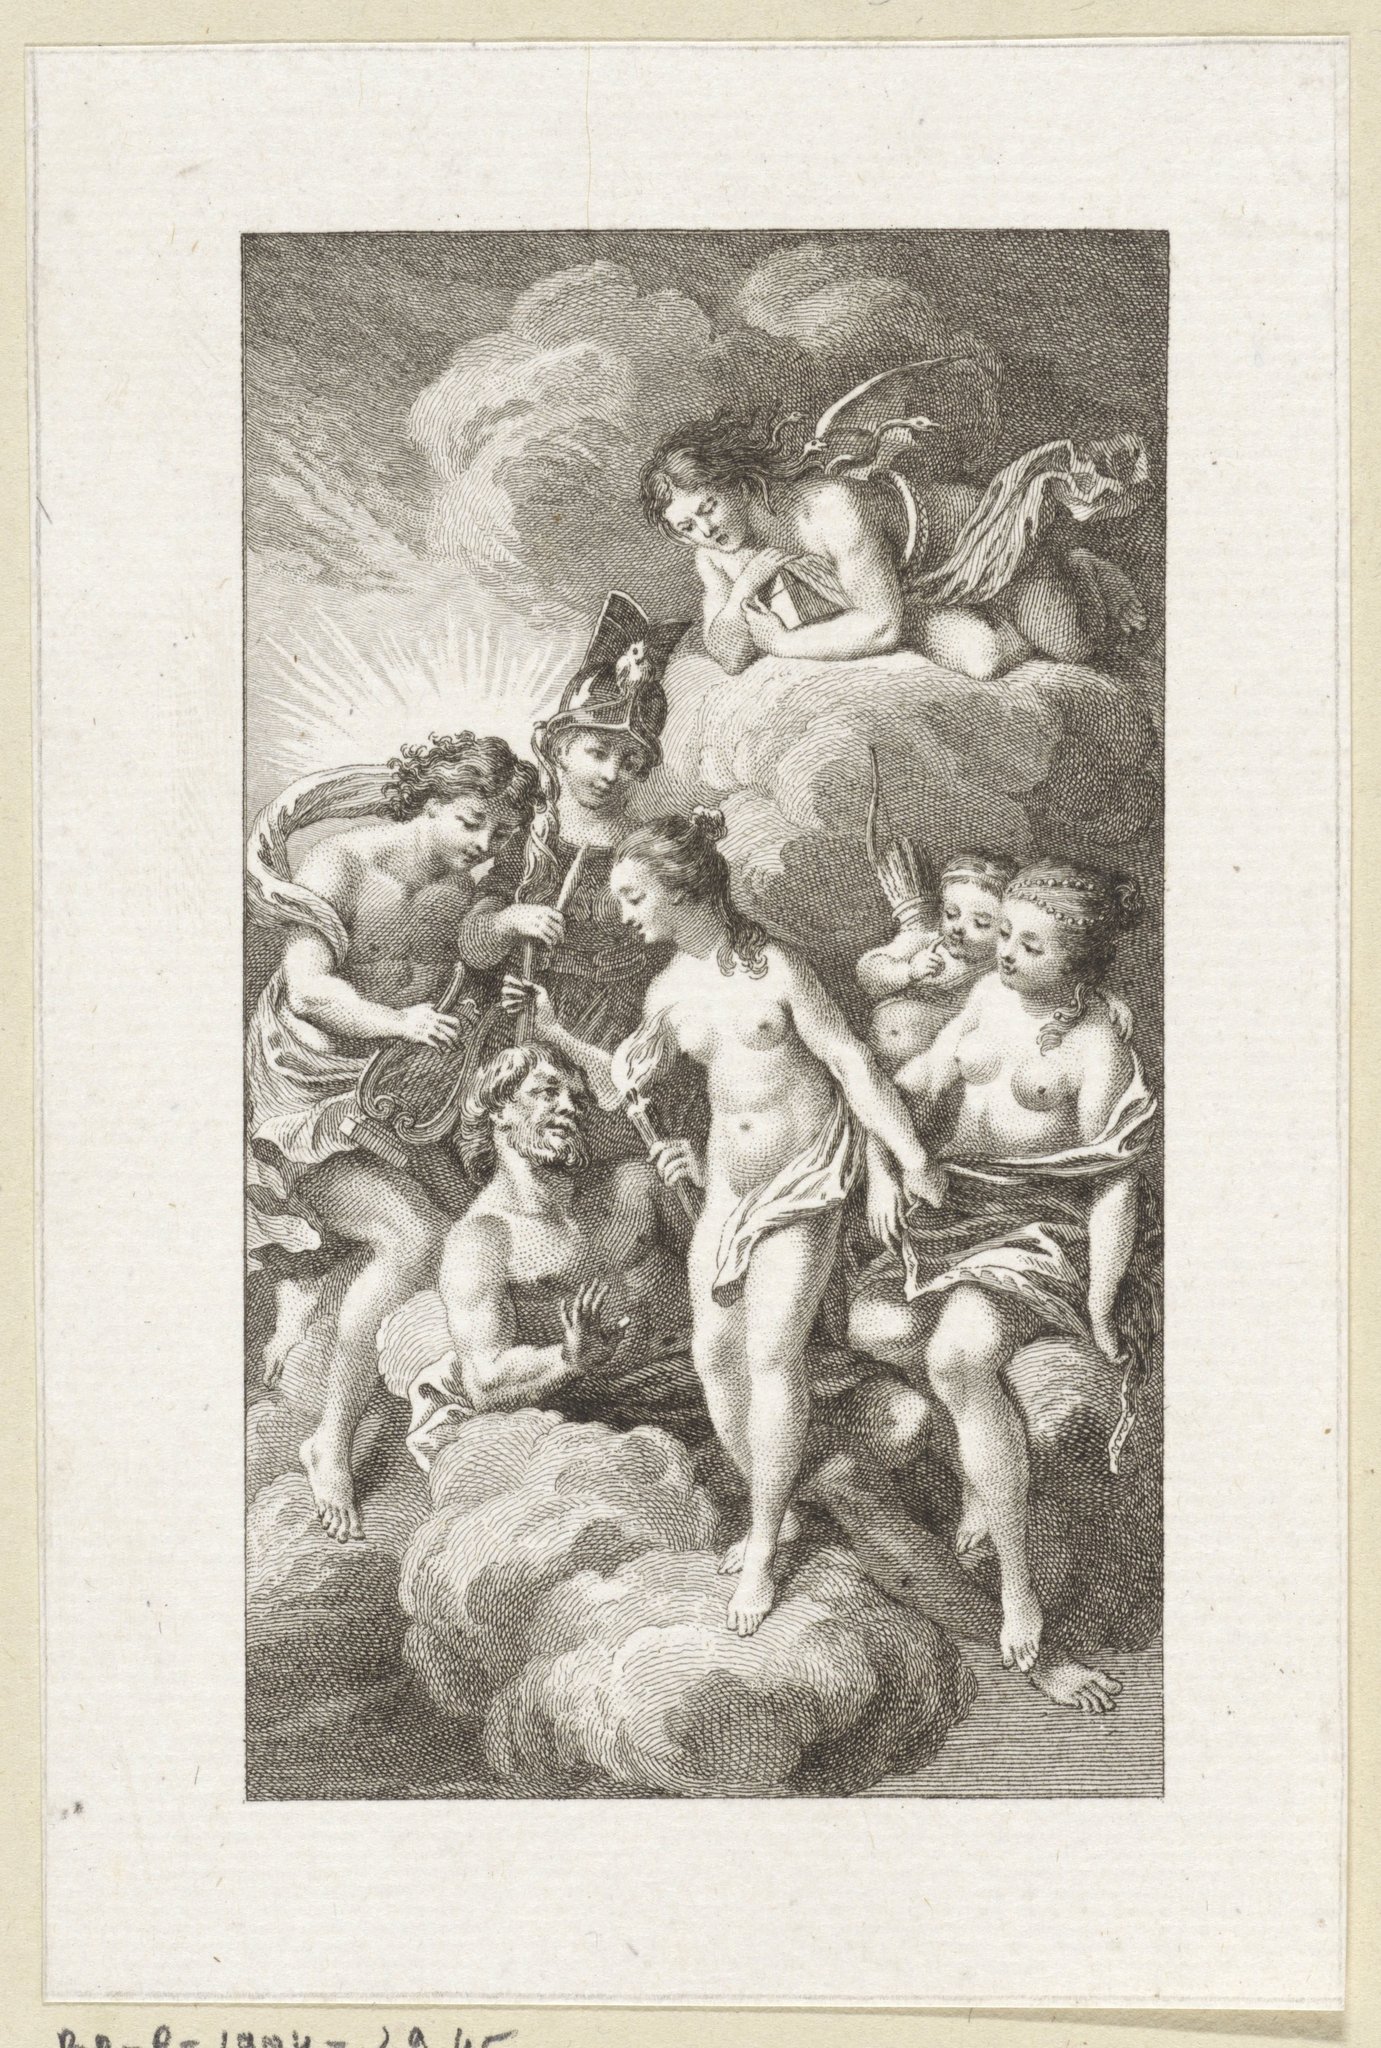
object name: print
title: Venus, Apollo, en andere goden en godinnen op de wolken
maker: reinier vinkeles (i)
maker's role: draughtsman, print maker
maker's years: 1741-1816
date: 1751-1816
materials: paper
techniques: engraving, etching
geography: amsterdam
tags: (story of) apollo (phoebus), clouds, (story of) venus (aphrodite), gods ~ classical mythology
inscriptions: collector's mark: Lugt 2228